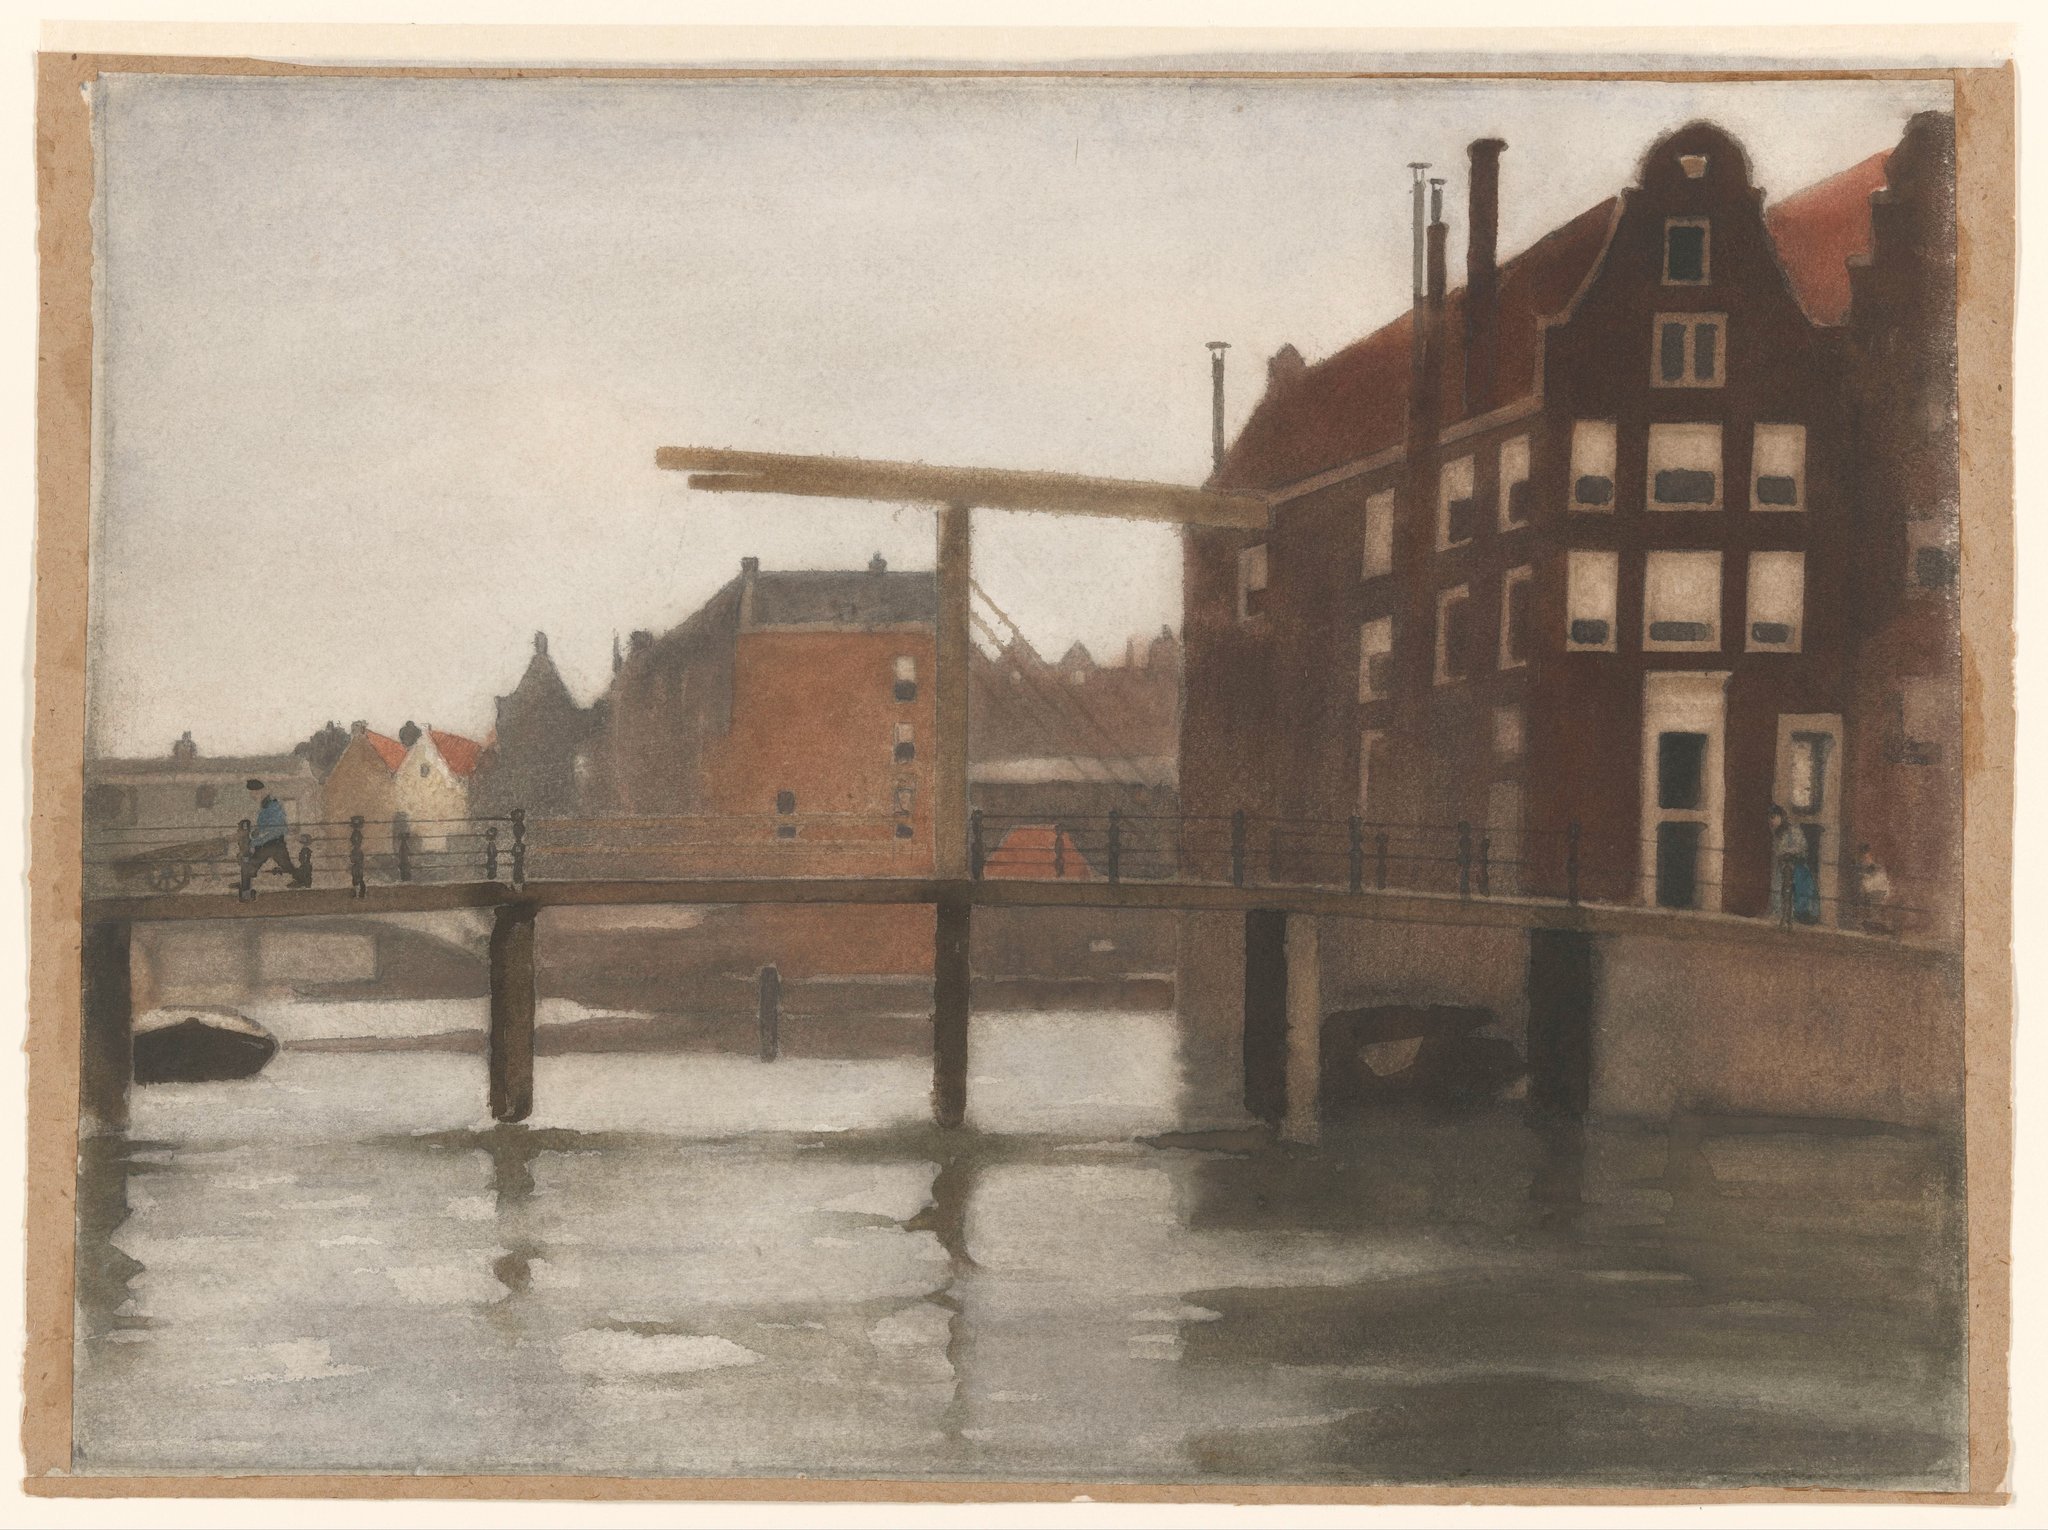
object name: watercolor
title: Brug tussen de eilanden Rapenburg en Uilenburg te Amsterdam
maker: willem witsen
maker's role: draughtsman, painter, print maker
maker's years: 1860-1923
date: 1911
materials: paper, pencil, watercolor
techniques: brush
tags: canals, waters (in city), bridge in city across river, canal, etc., amsterdam